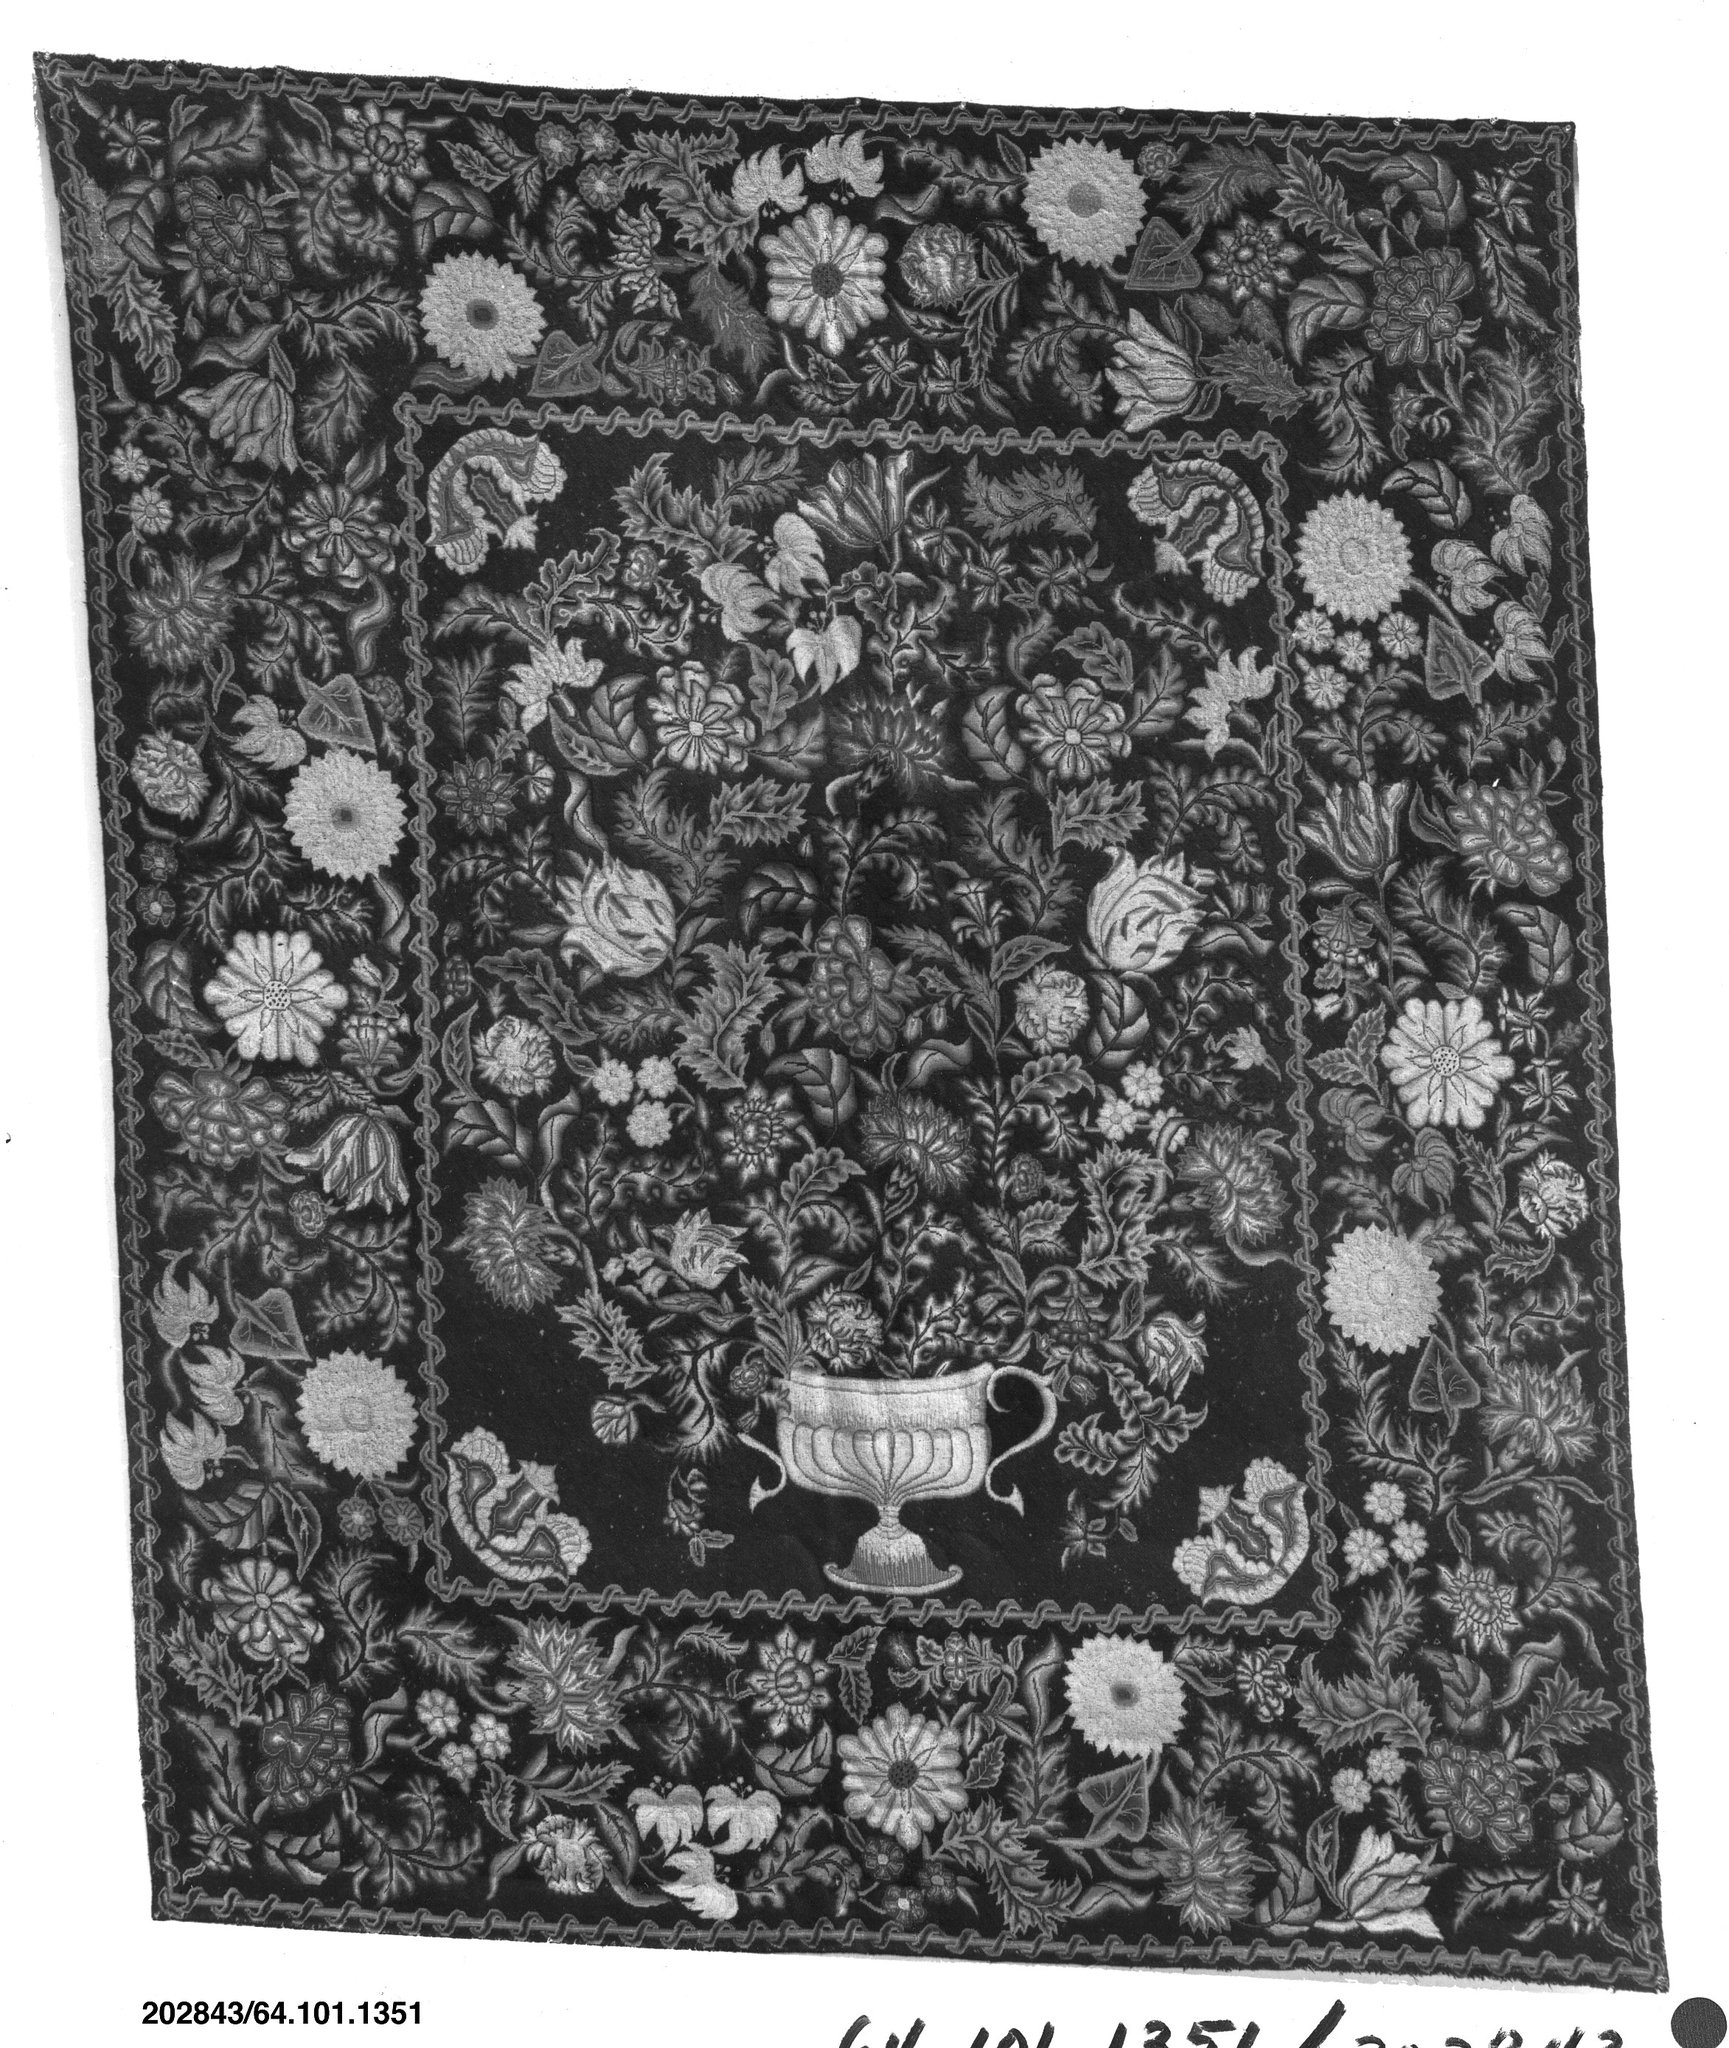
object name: carpet or hanging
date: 1725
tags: flowers